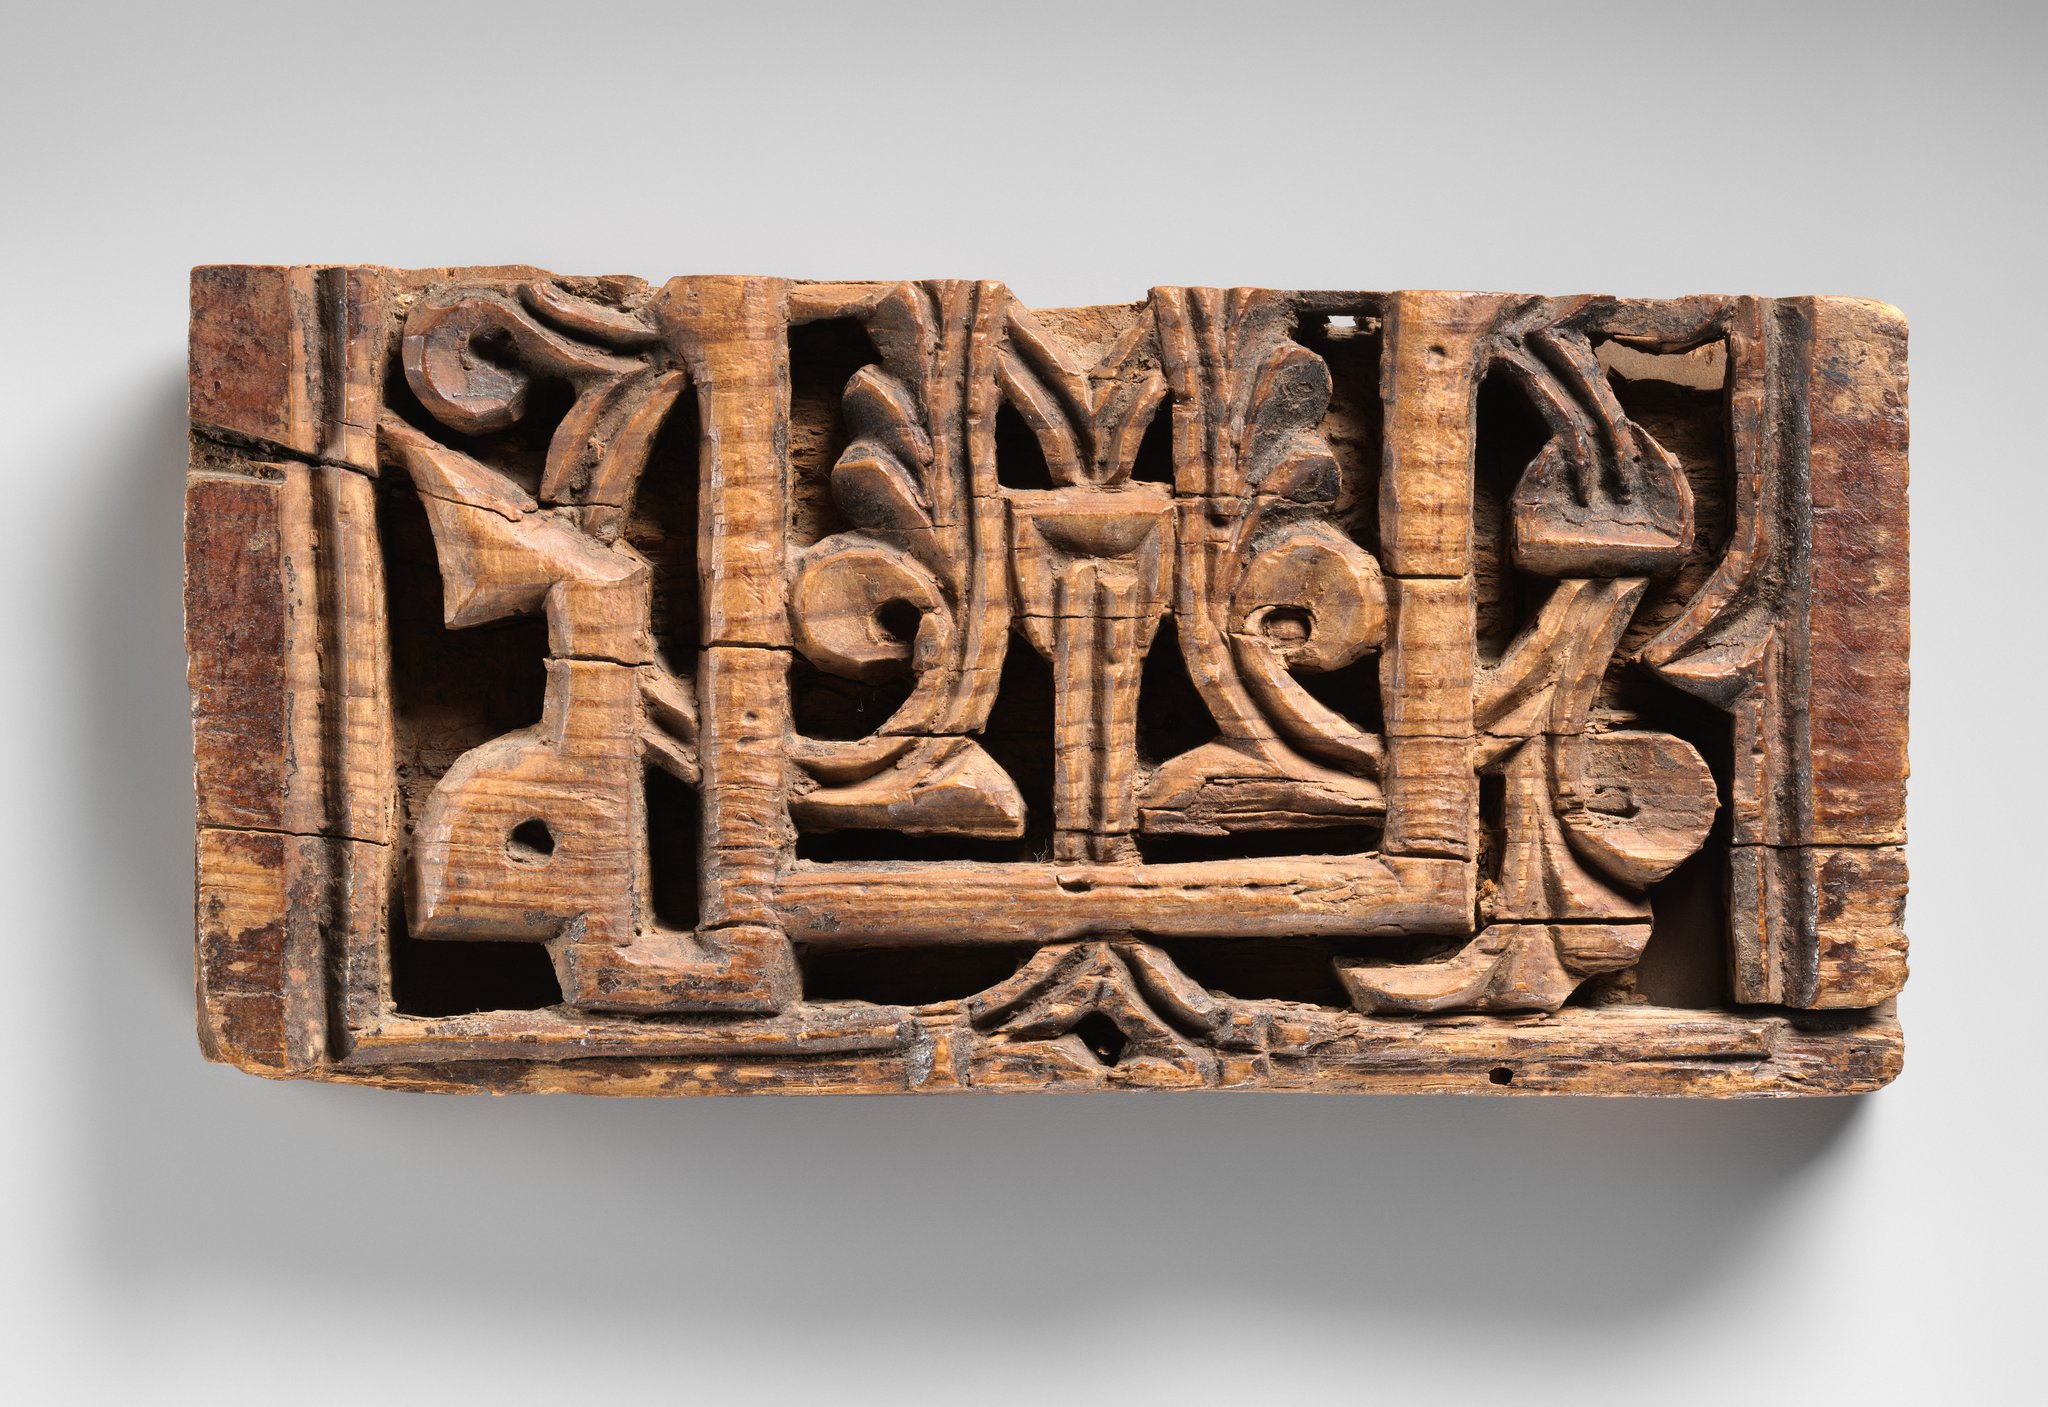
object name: panel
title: Wood Panel with Calligraphy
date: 1001-1100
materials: wood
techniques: carving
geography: spain